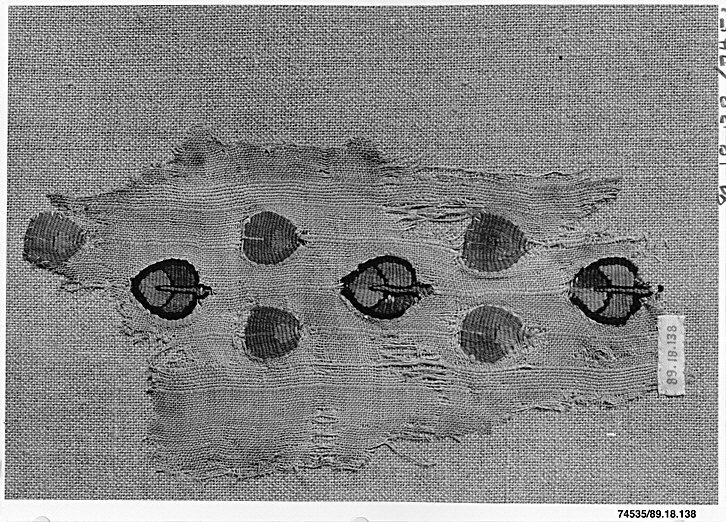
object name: textile fragment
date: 401-500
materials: linen, wool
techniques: weave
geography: egypt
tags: leaves